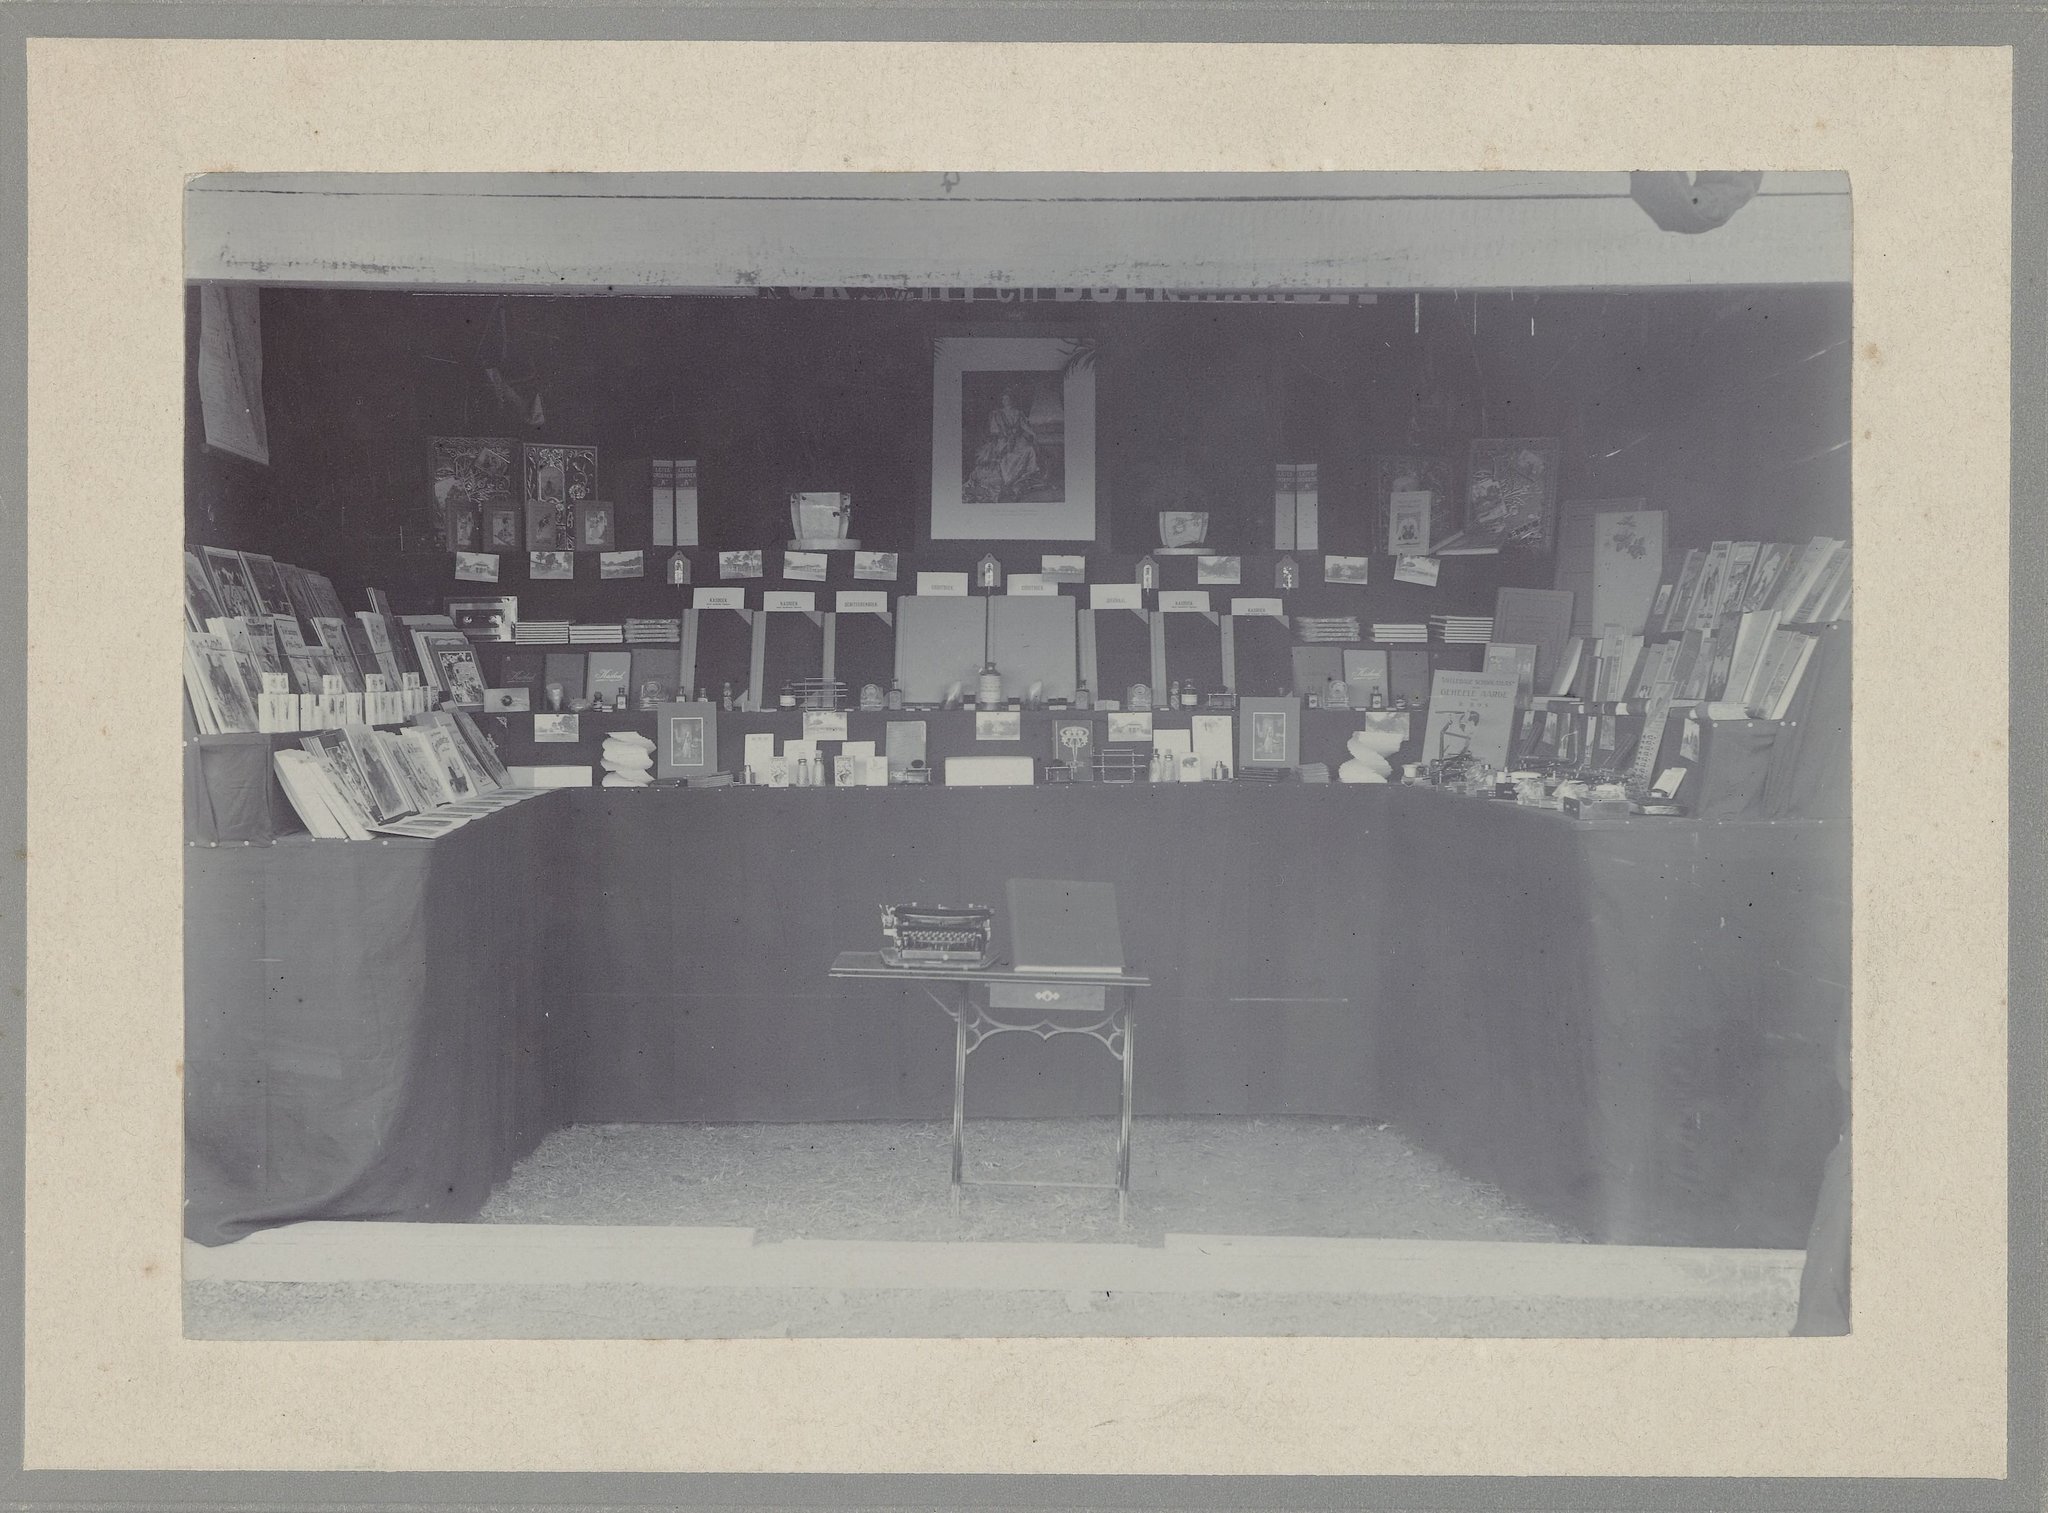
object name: photograph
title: Tentoonstelling door Atjeh Drukkerij te Koeta-Radja in 1911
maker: Anonymous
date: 1905-1911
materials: cardboard, photographic support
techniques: collodion silver print, gelatin silver print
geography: banda atjeh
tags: dutch east indies, the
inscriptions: inscription: ‘Tentoonstelling mei 1911 / Koeta-Radja’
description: Tentoonstelling van drukwerk vervaardigd door de Atjeh Drukkerij te Koeta-Radja (Banda Atjeh) in mei 1911. Uitstalling van kinderboeken, atlassen, foto's, prentbriefkaart, prenten, prentenboeken en artikelen uit de kantoorboekhandel, vooraan een tafeltje met een schrijfmachine. Foto opgeplakt op karton. Onderdeel van een groep van negen foto's over de Atjeh-drukkerij.